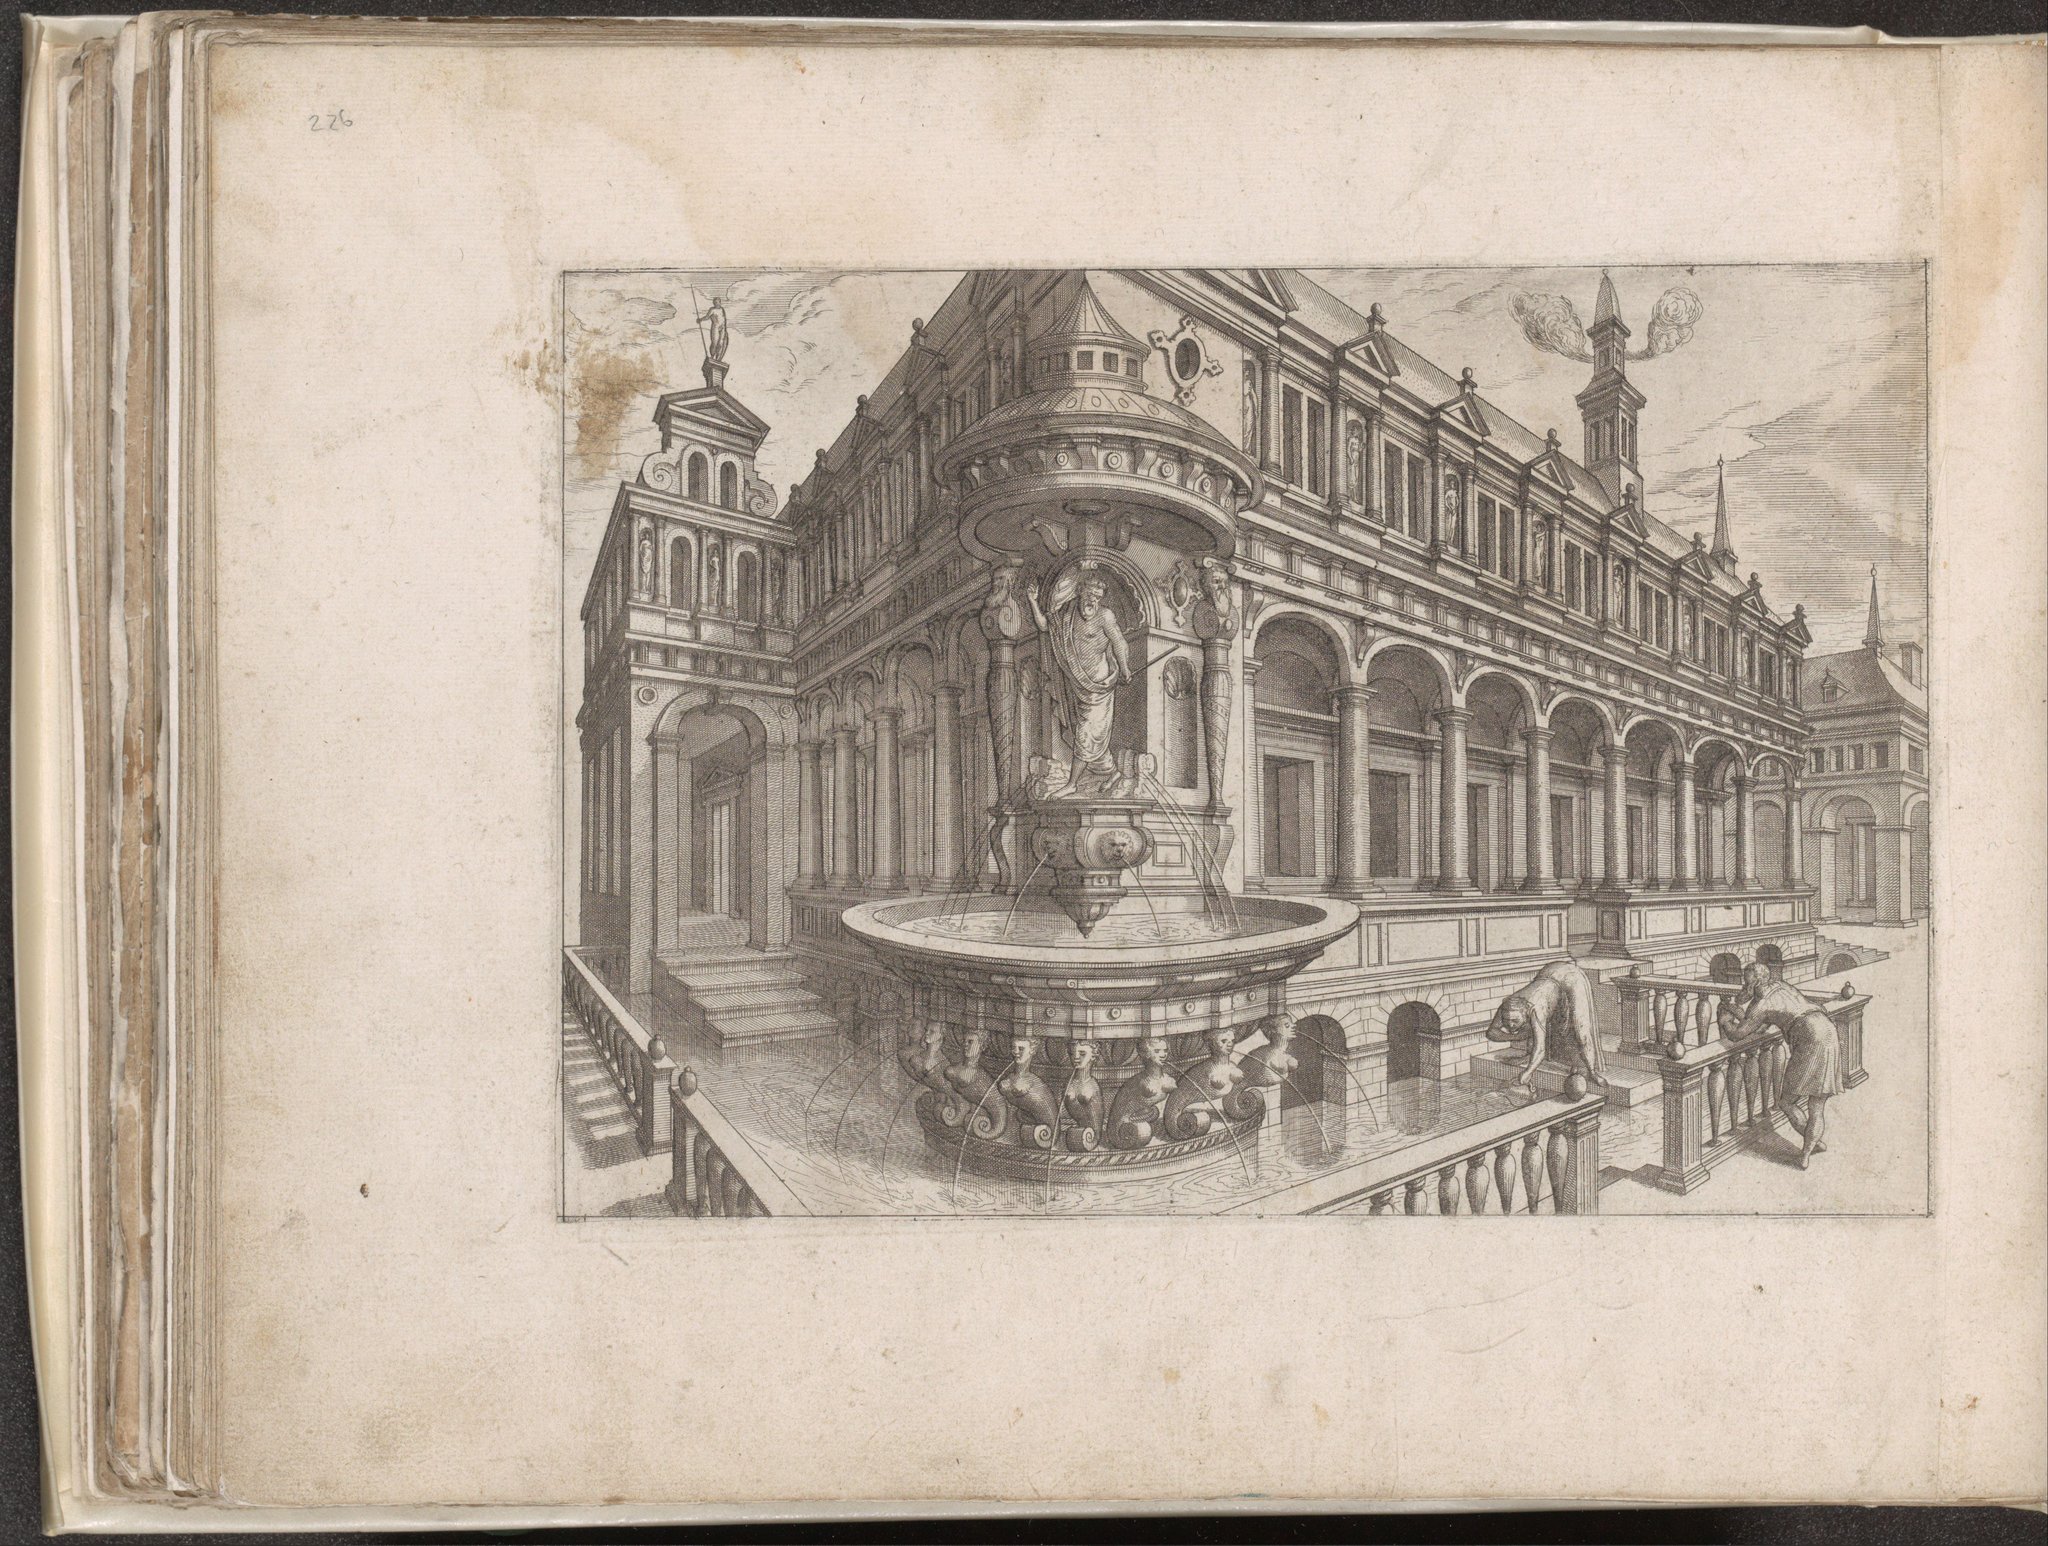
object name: album leaf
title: Artis Perspectivae (...)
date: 1568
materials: paper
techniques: etching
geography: antwerp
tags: moses (not in biblical context); possible attributes: rays of light or horns on his head, rod, tables of the law, piece of sculpture, reproduction of a piece of sculpture, ornamental fountain, civic architecture; edifices; dwellings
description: Muurfontein op de hoek van een gebouw met een standbeeld van Mozes in een nis. Rechts leunt een man tegen de balustrade. Deze prent maakt deel uit van een album.